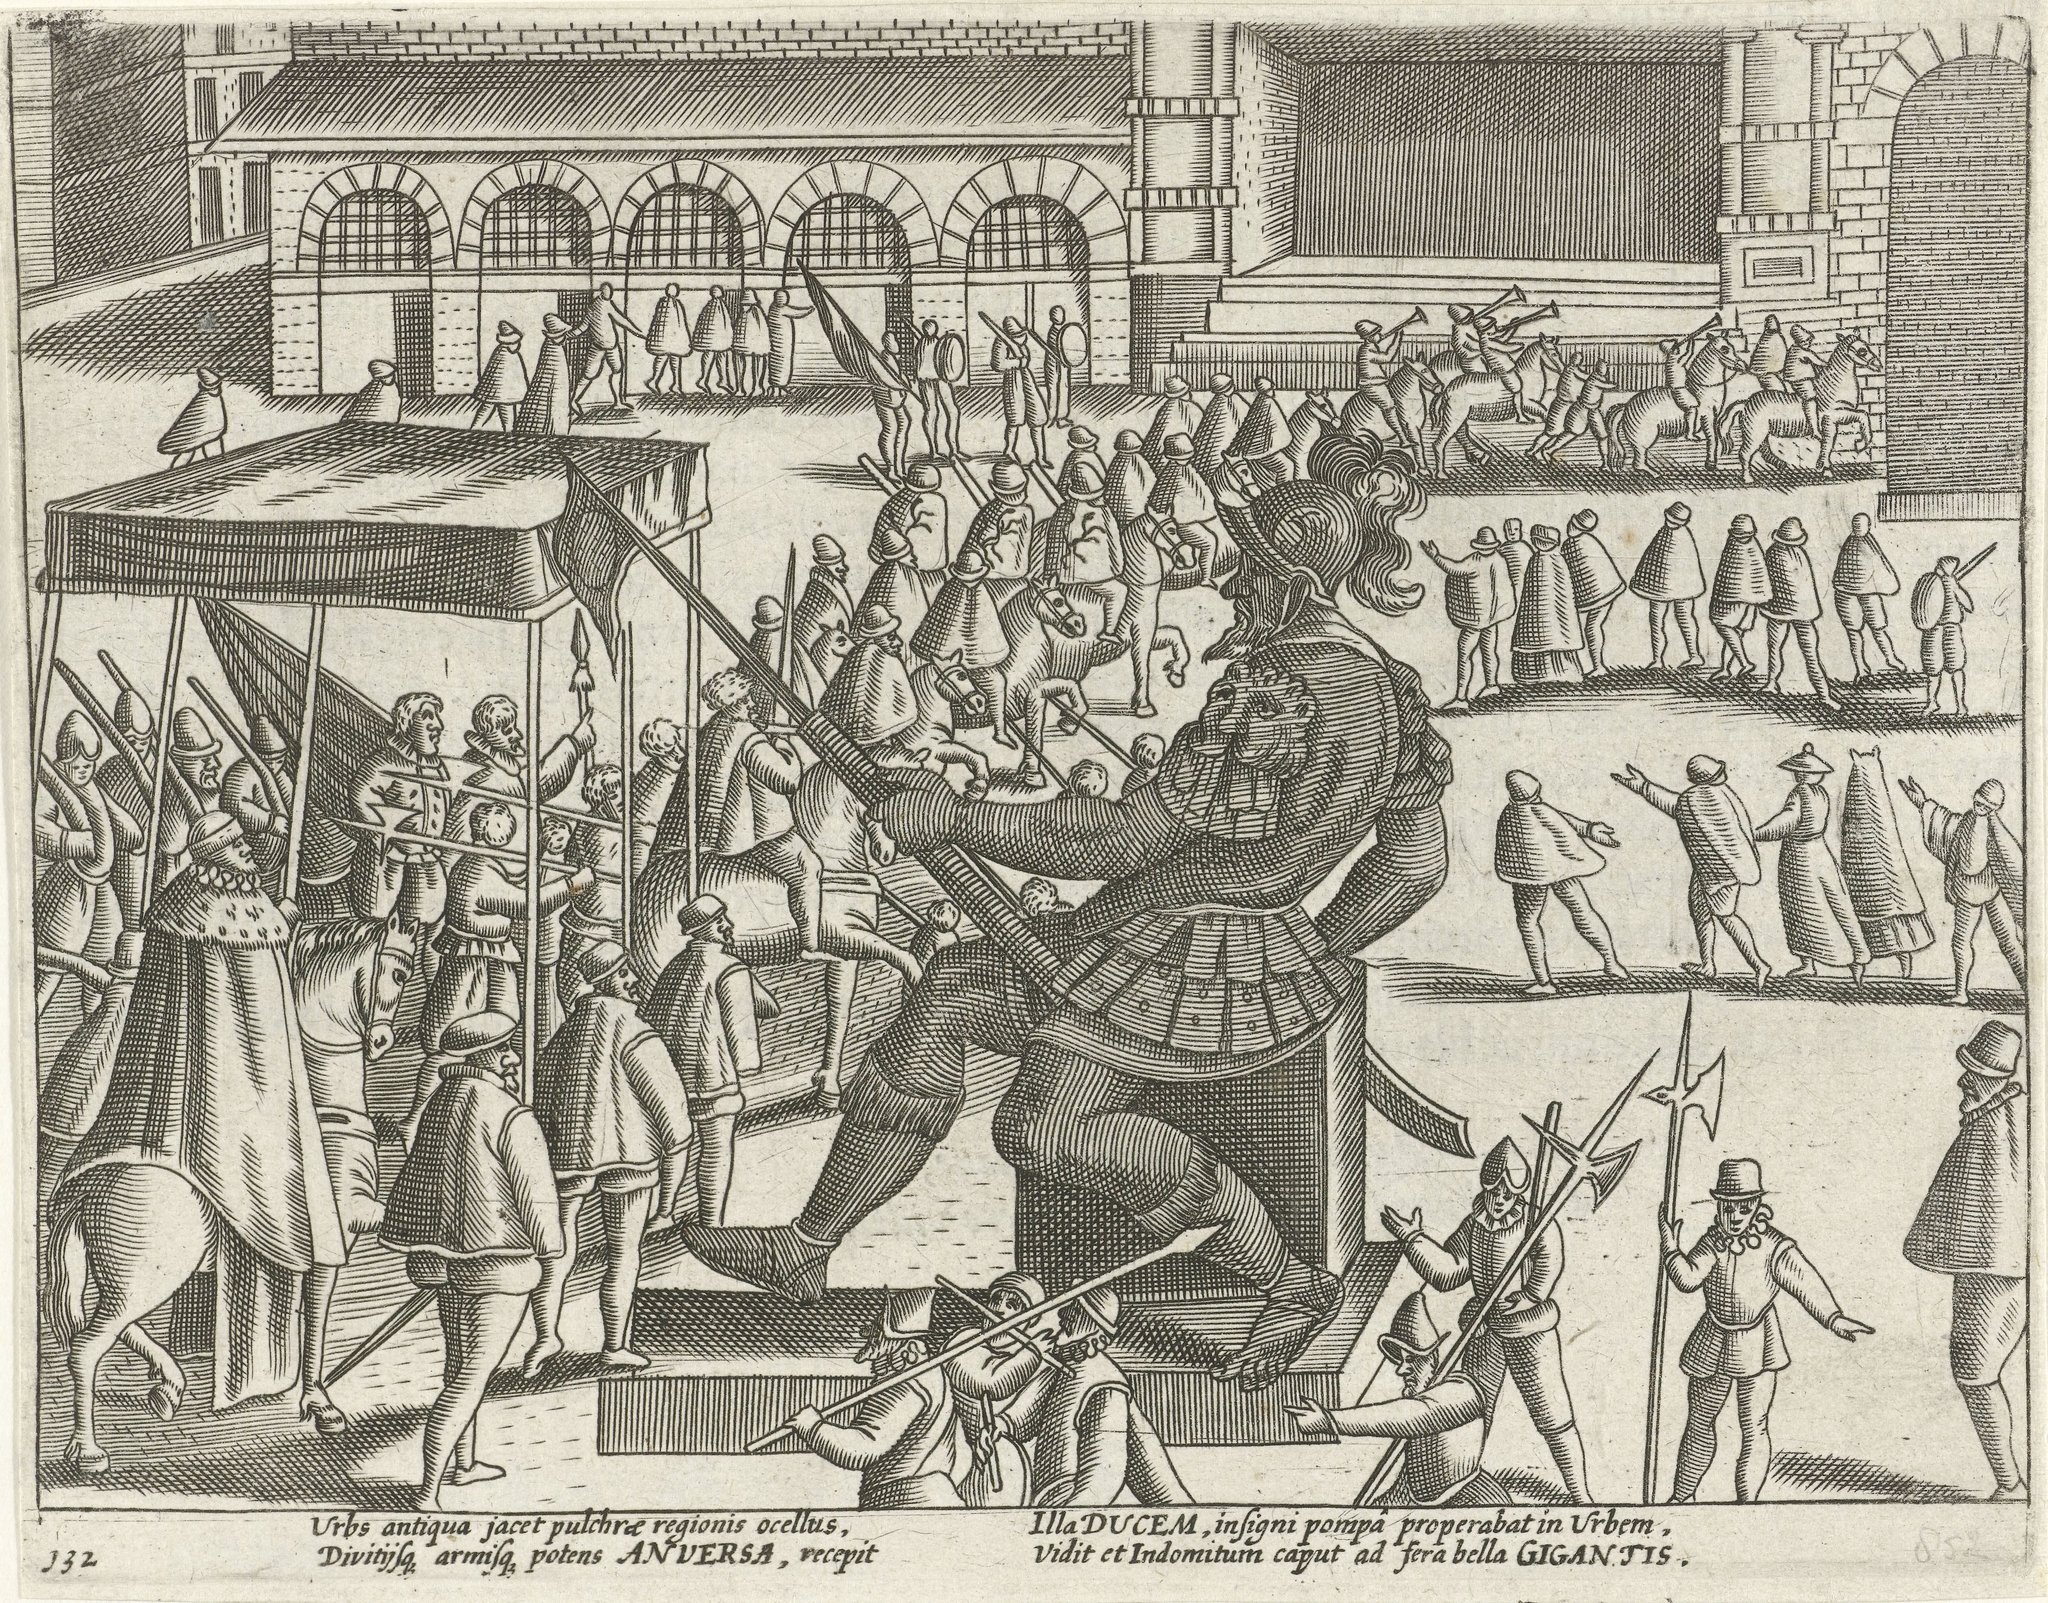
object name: history print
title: De stoet trekt langs het beeld van de reus Antigoon op de Grote Markt, 1582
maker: Anonymous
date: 1613-1615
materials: paper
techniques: etching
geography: northern netherlands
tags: françois-hercule de valois (hertog van anjou), triumphal entry and public reception, pageant, 'entrée solennelle', 'joyeuse entrée', giants, colossi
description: De stoet trekt langs het beeld van de reus Antigoon op de Grote Markt, 1582. Onderdeel van de feestelijke intocht van de hertog van Anjou te Antwerpen op 19 februari 1582. Met onderschrift van 4 regels in het Latijn. Genummerd 132. Bedrukt op achterzijde met tekst in het Latijn.